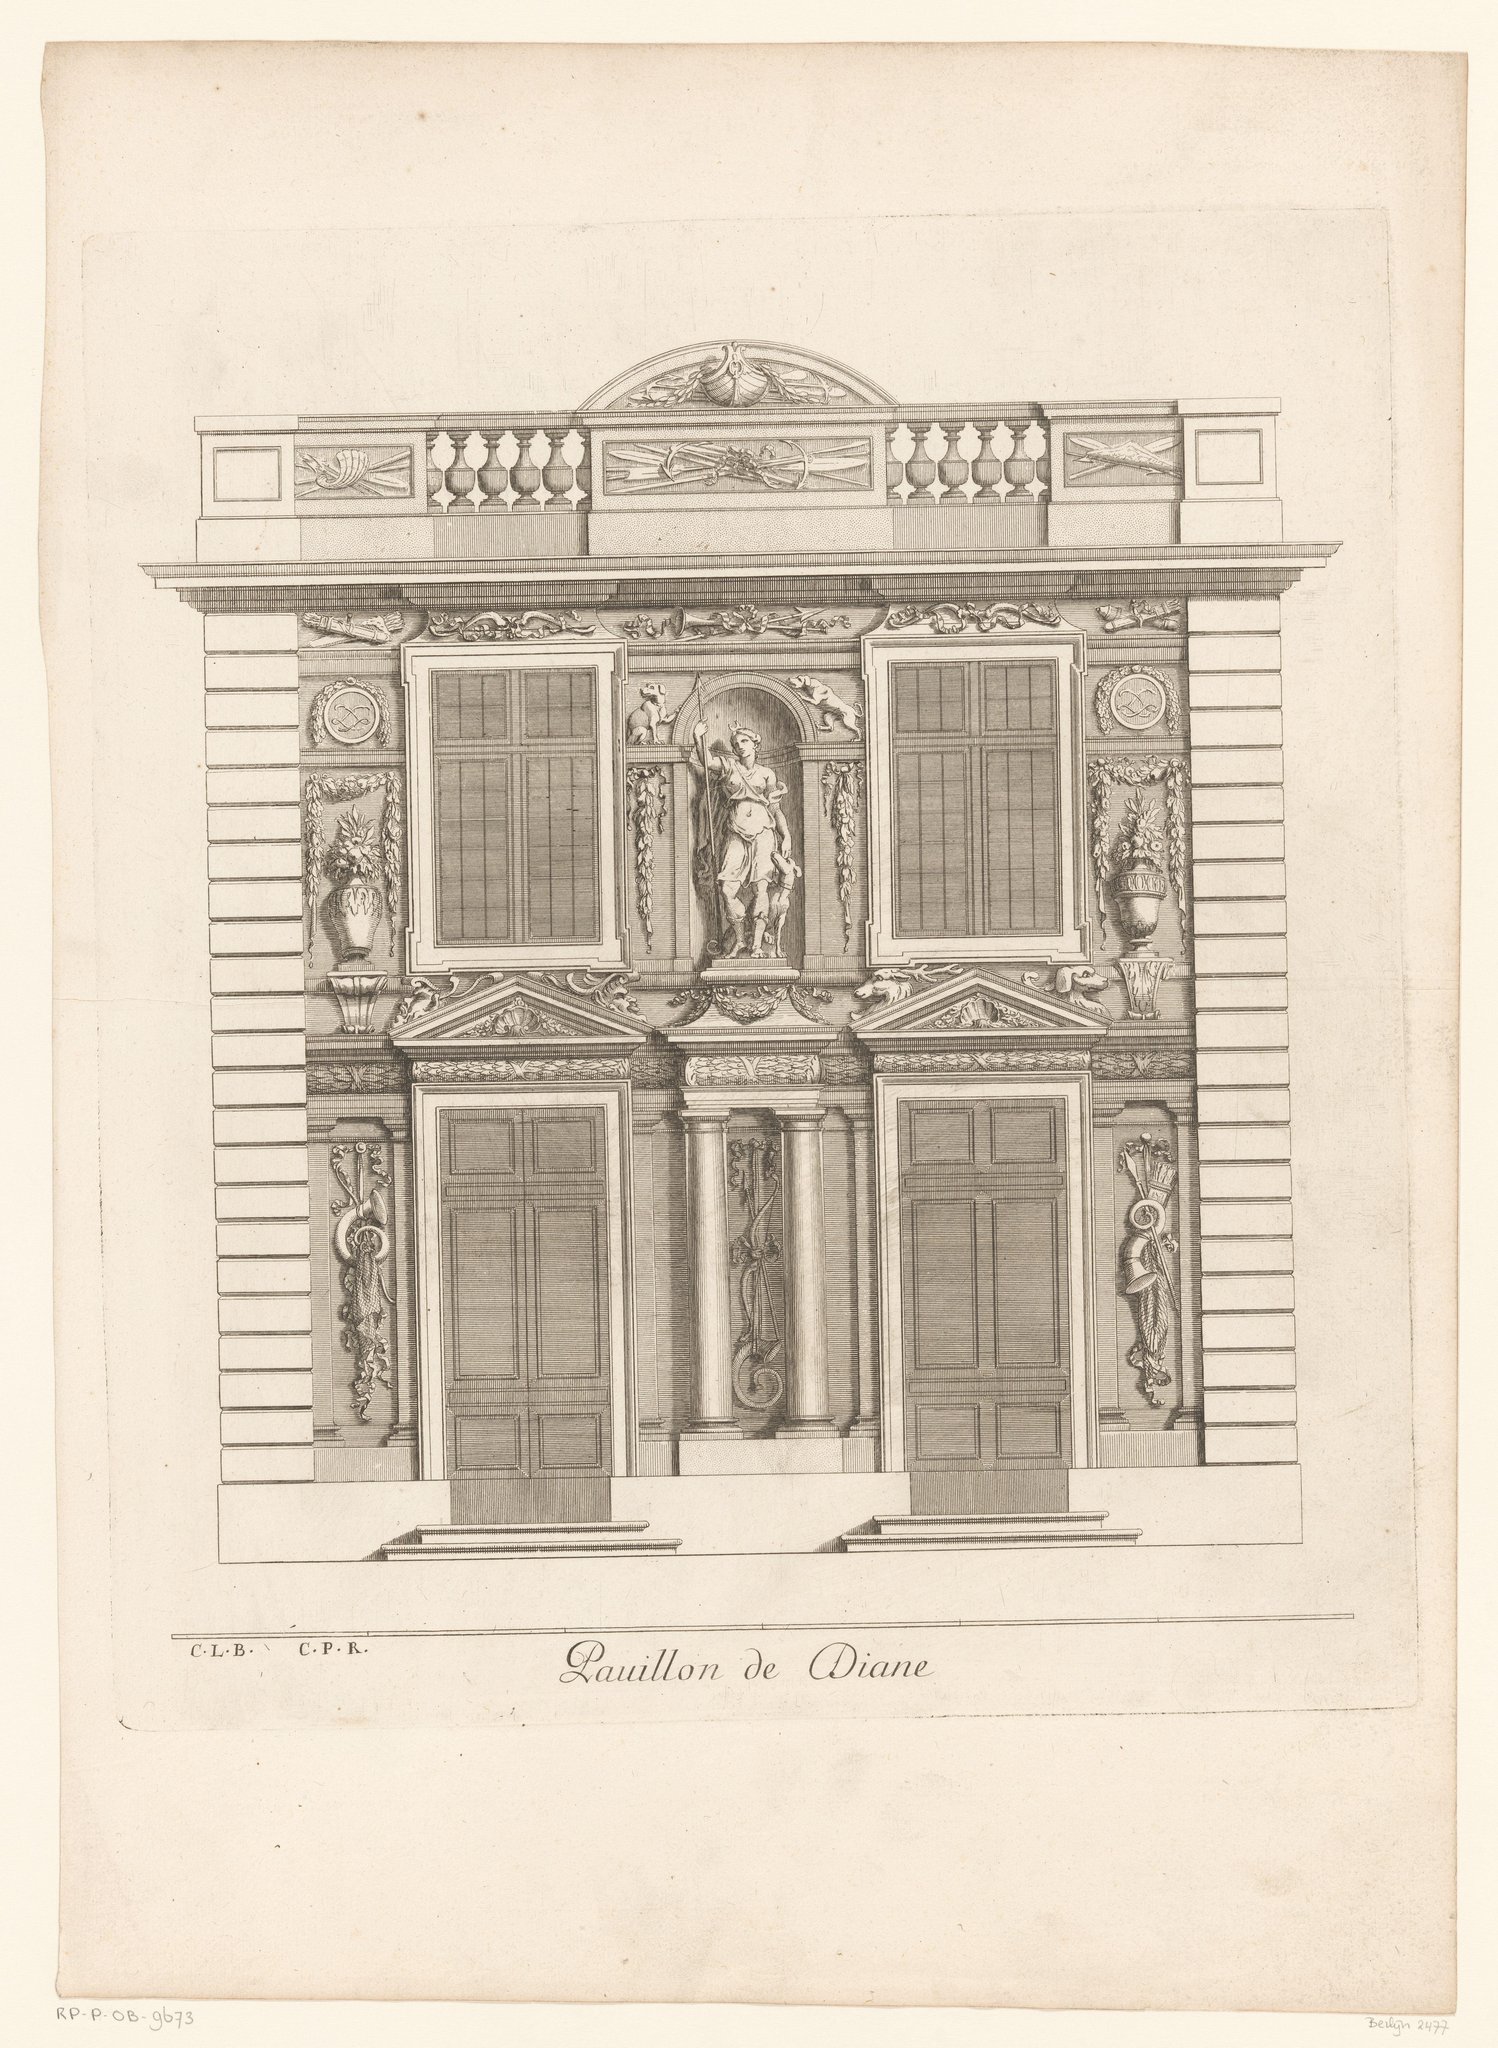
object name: print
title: Paviljoen van Diana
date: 1672-1686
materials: paper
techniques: etching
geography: paris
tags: (story of) diana (artemis), façade (of house or building)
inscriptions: collector's mark: Lugt 2228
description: Façade van een paviljoen met toscaanse zuilen, pilasters, jachttrofeeën, vazen, Diana staand in een nis en een balustrade aan de bovenzijde.